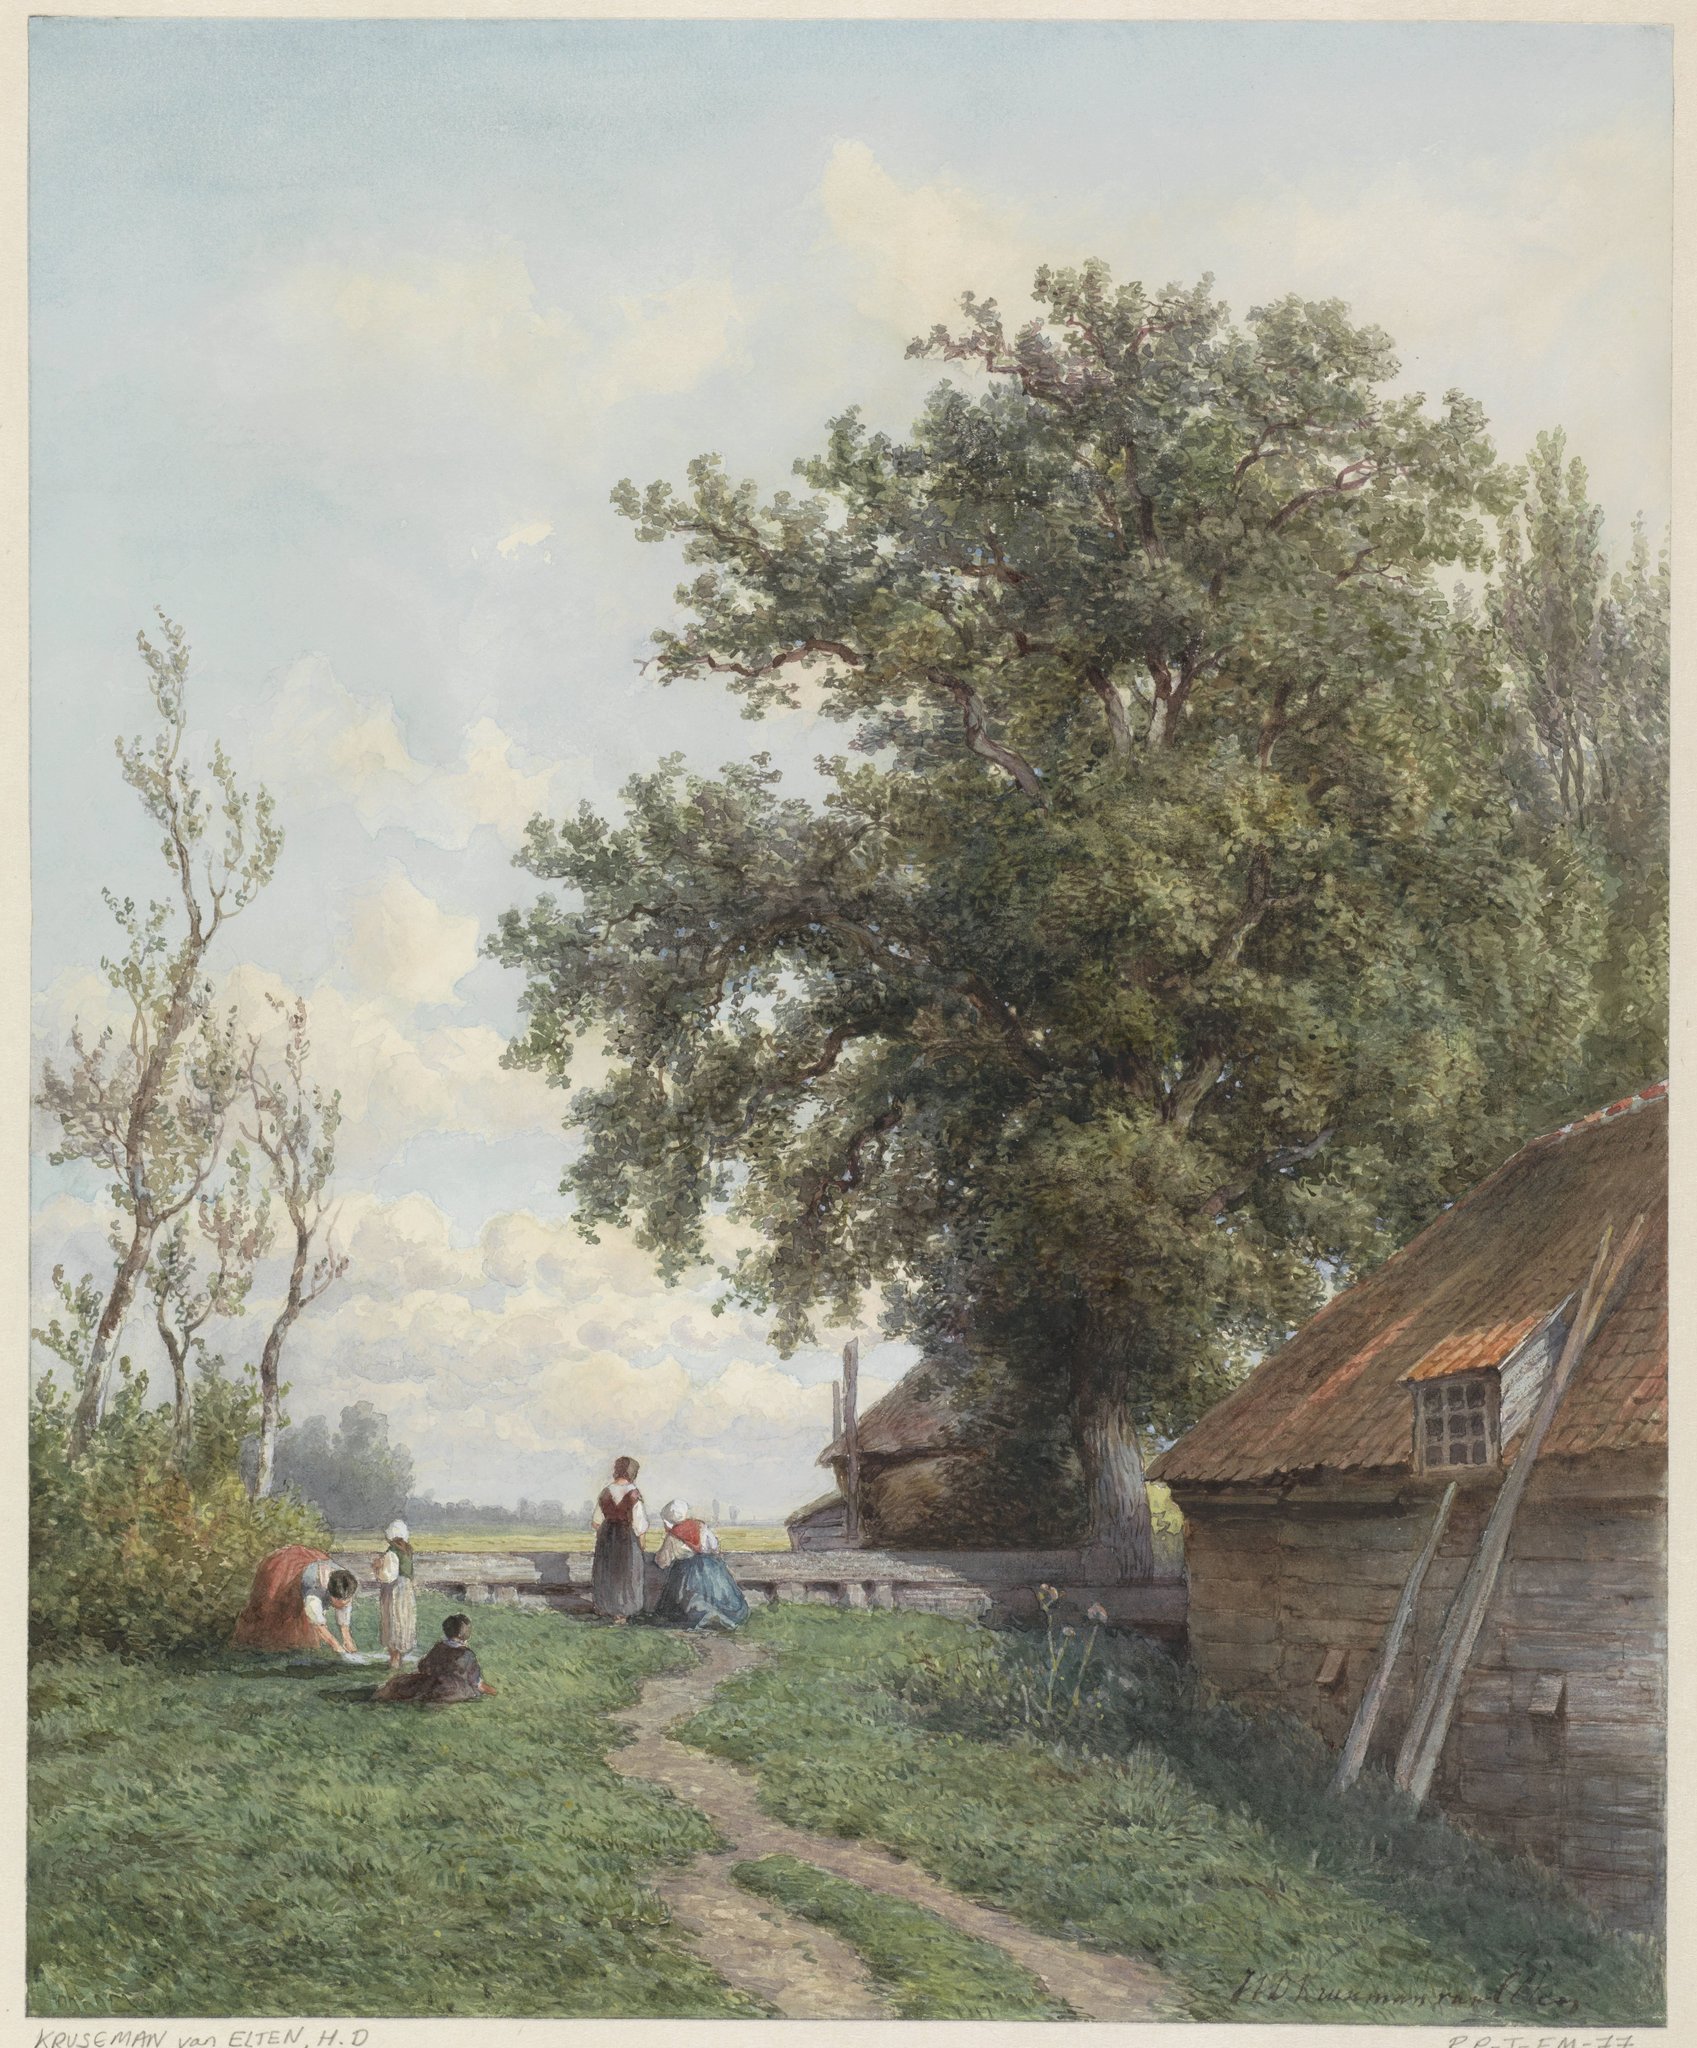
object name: drawing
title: Boerenerf met enige figuren, rechts een schuur en grote boom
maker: hendrik dirk kruseman van elten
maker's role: draughtsman, print maker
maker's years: 1829-1904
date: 1839-1904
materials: paper, watercolor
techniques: brush